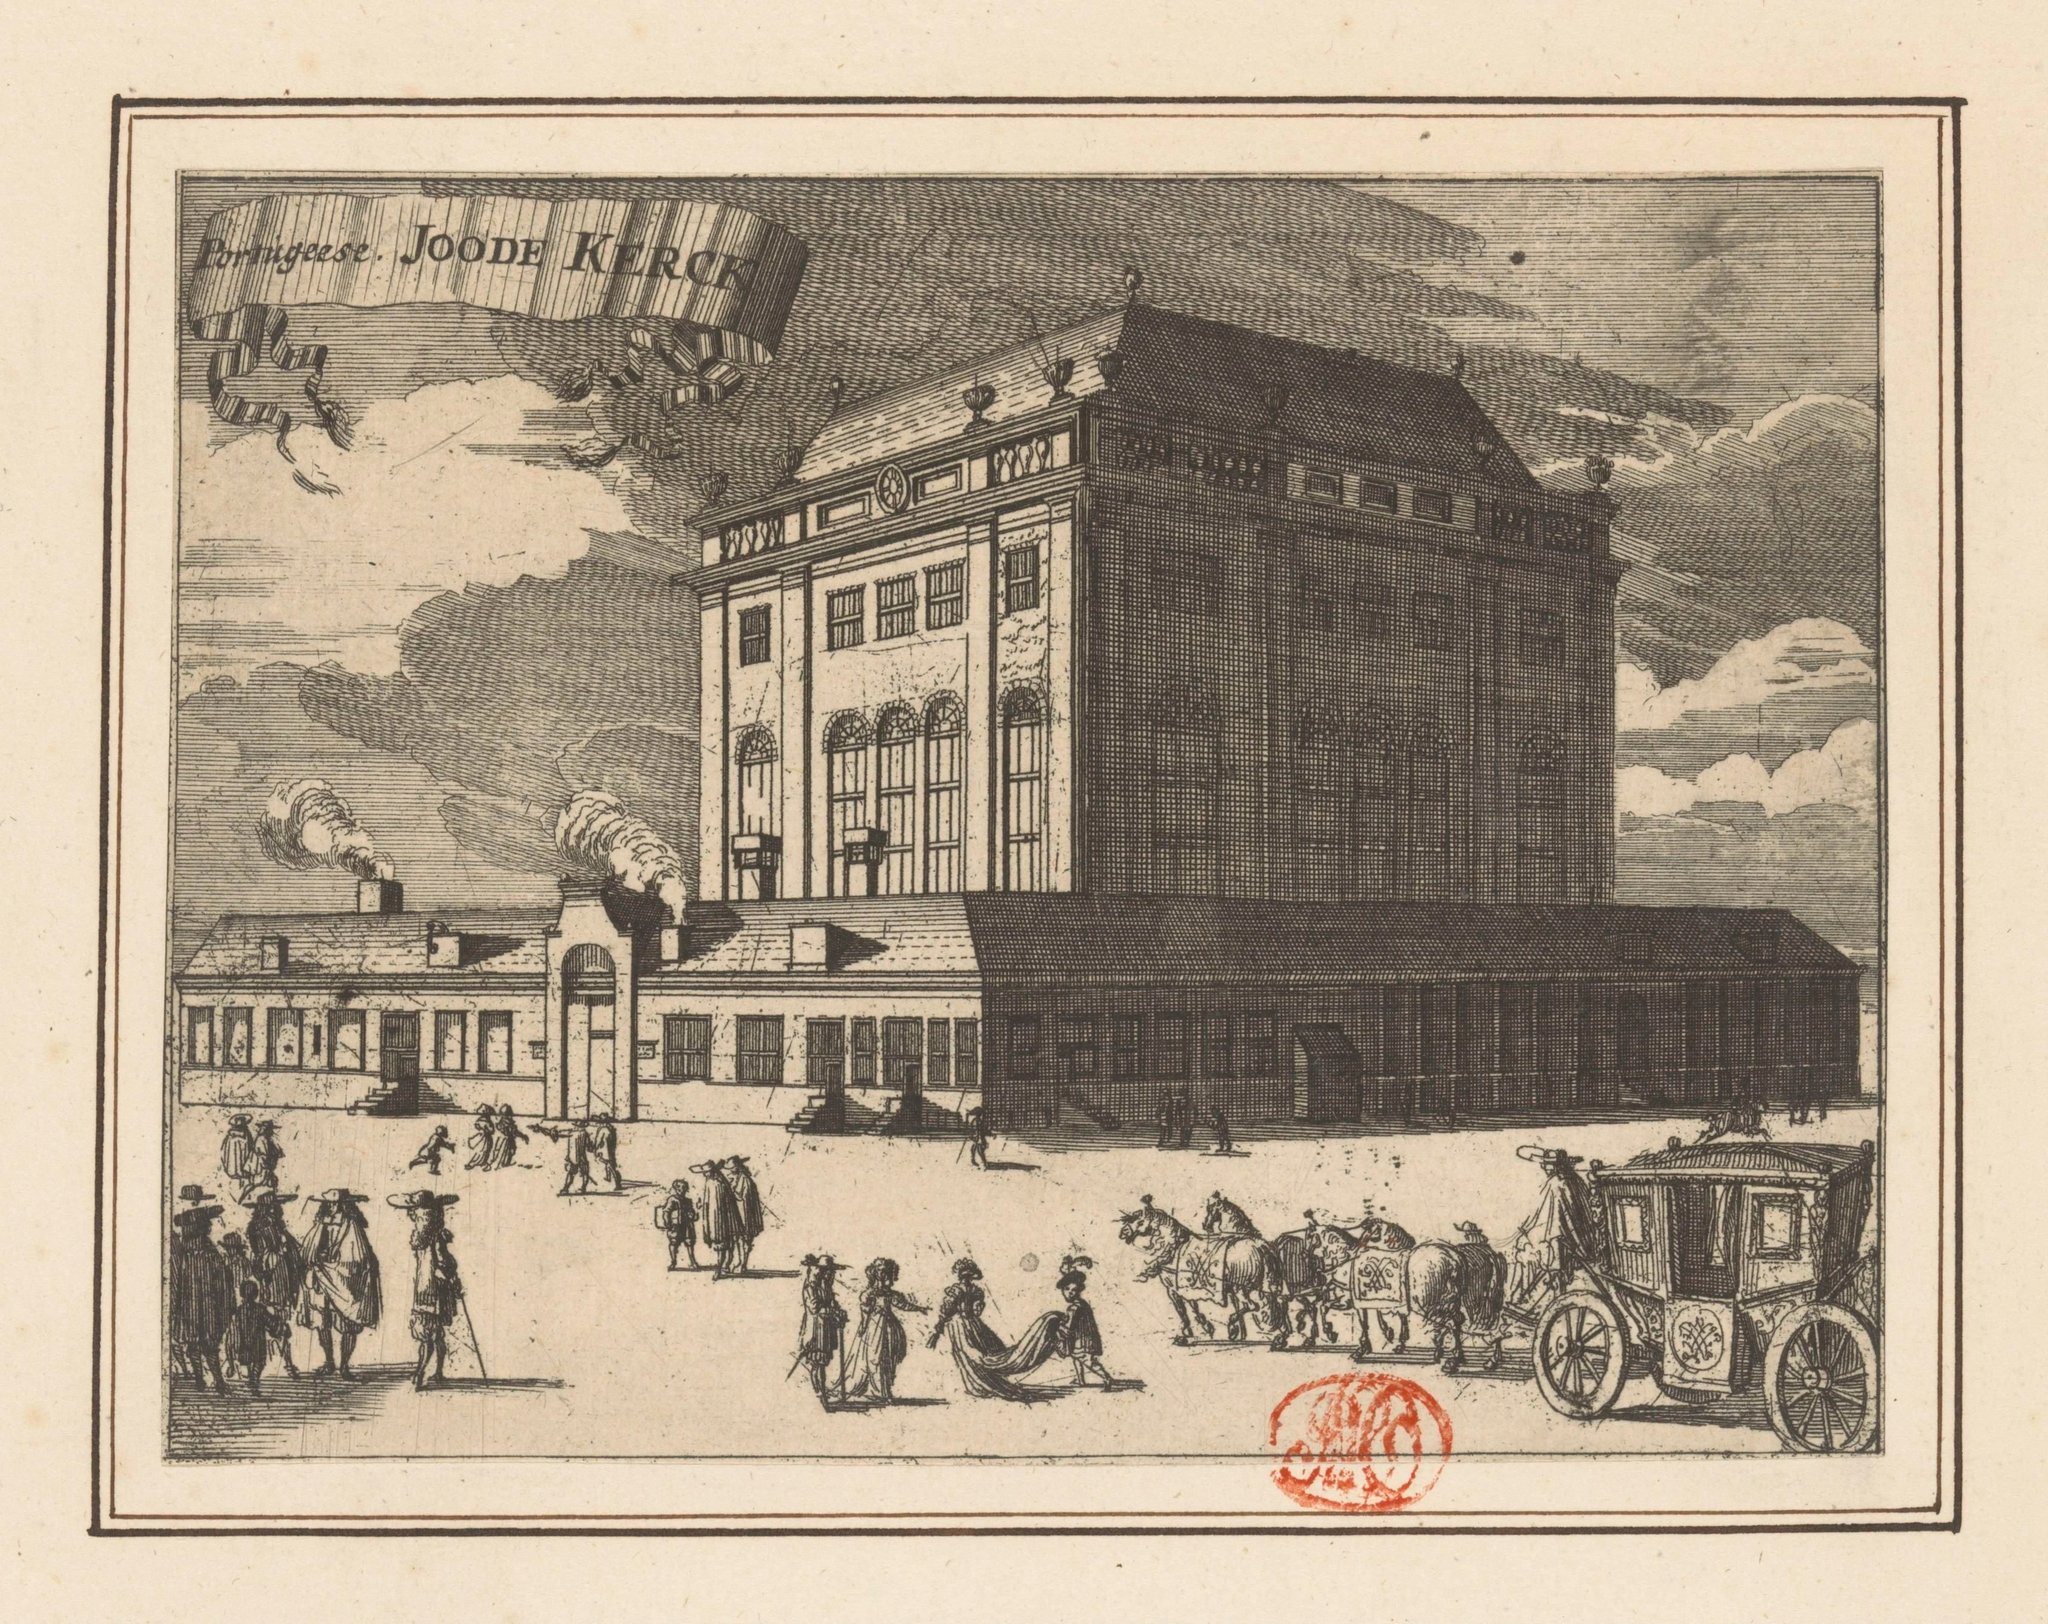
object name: print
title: Portugeese Joode Kerck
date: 1675-1725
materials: paper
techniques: engraving, etching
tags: 'sephardim' ~ jewish communities, the synagogue (as building and place of worship ~ jewish religion), street (+ city(-scape) with figures, staffage)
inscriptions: collector's mark: Lugt 195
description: Vermoedelijk onderdeel van een reeks prenten van gebouwen in Amsterdam (zie 'Portugeese Joode Kerck', 'Stadthuys ende Waegh', 'De Beurs', 'S. Lants. Magasyn', 'Lütherse Kerck', 'Ooster Kerck', 'Hooghduijtse Joode Kerck', 'Admiralitijts Werf' en 'De Amstel Sluys' op http://mapy.mzk.cz/en/mollova-sbirka/atlas-austriacus/XXIX//). Mogelijk zijn deze prenten uitgegeven als onderdeel van de randprenten van een kaart: 'Amstelodamum cum antiquis et nuperrimis pomoeriis'.